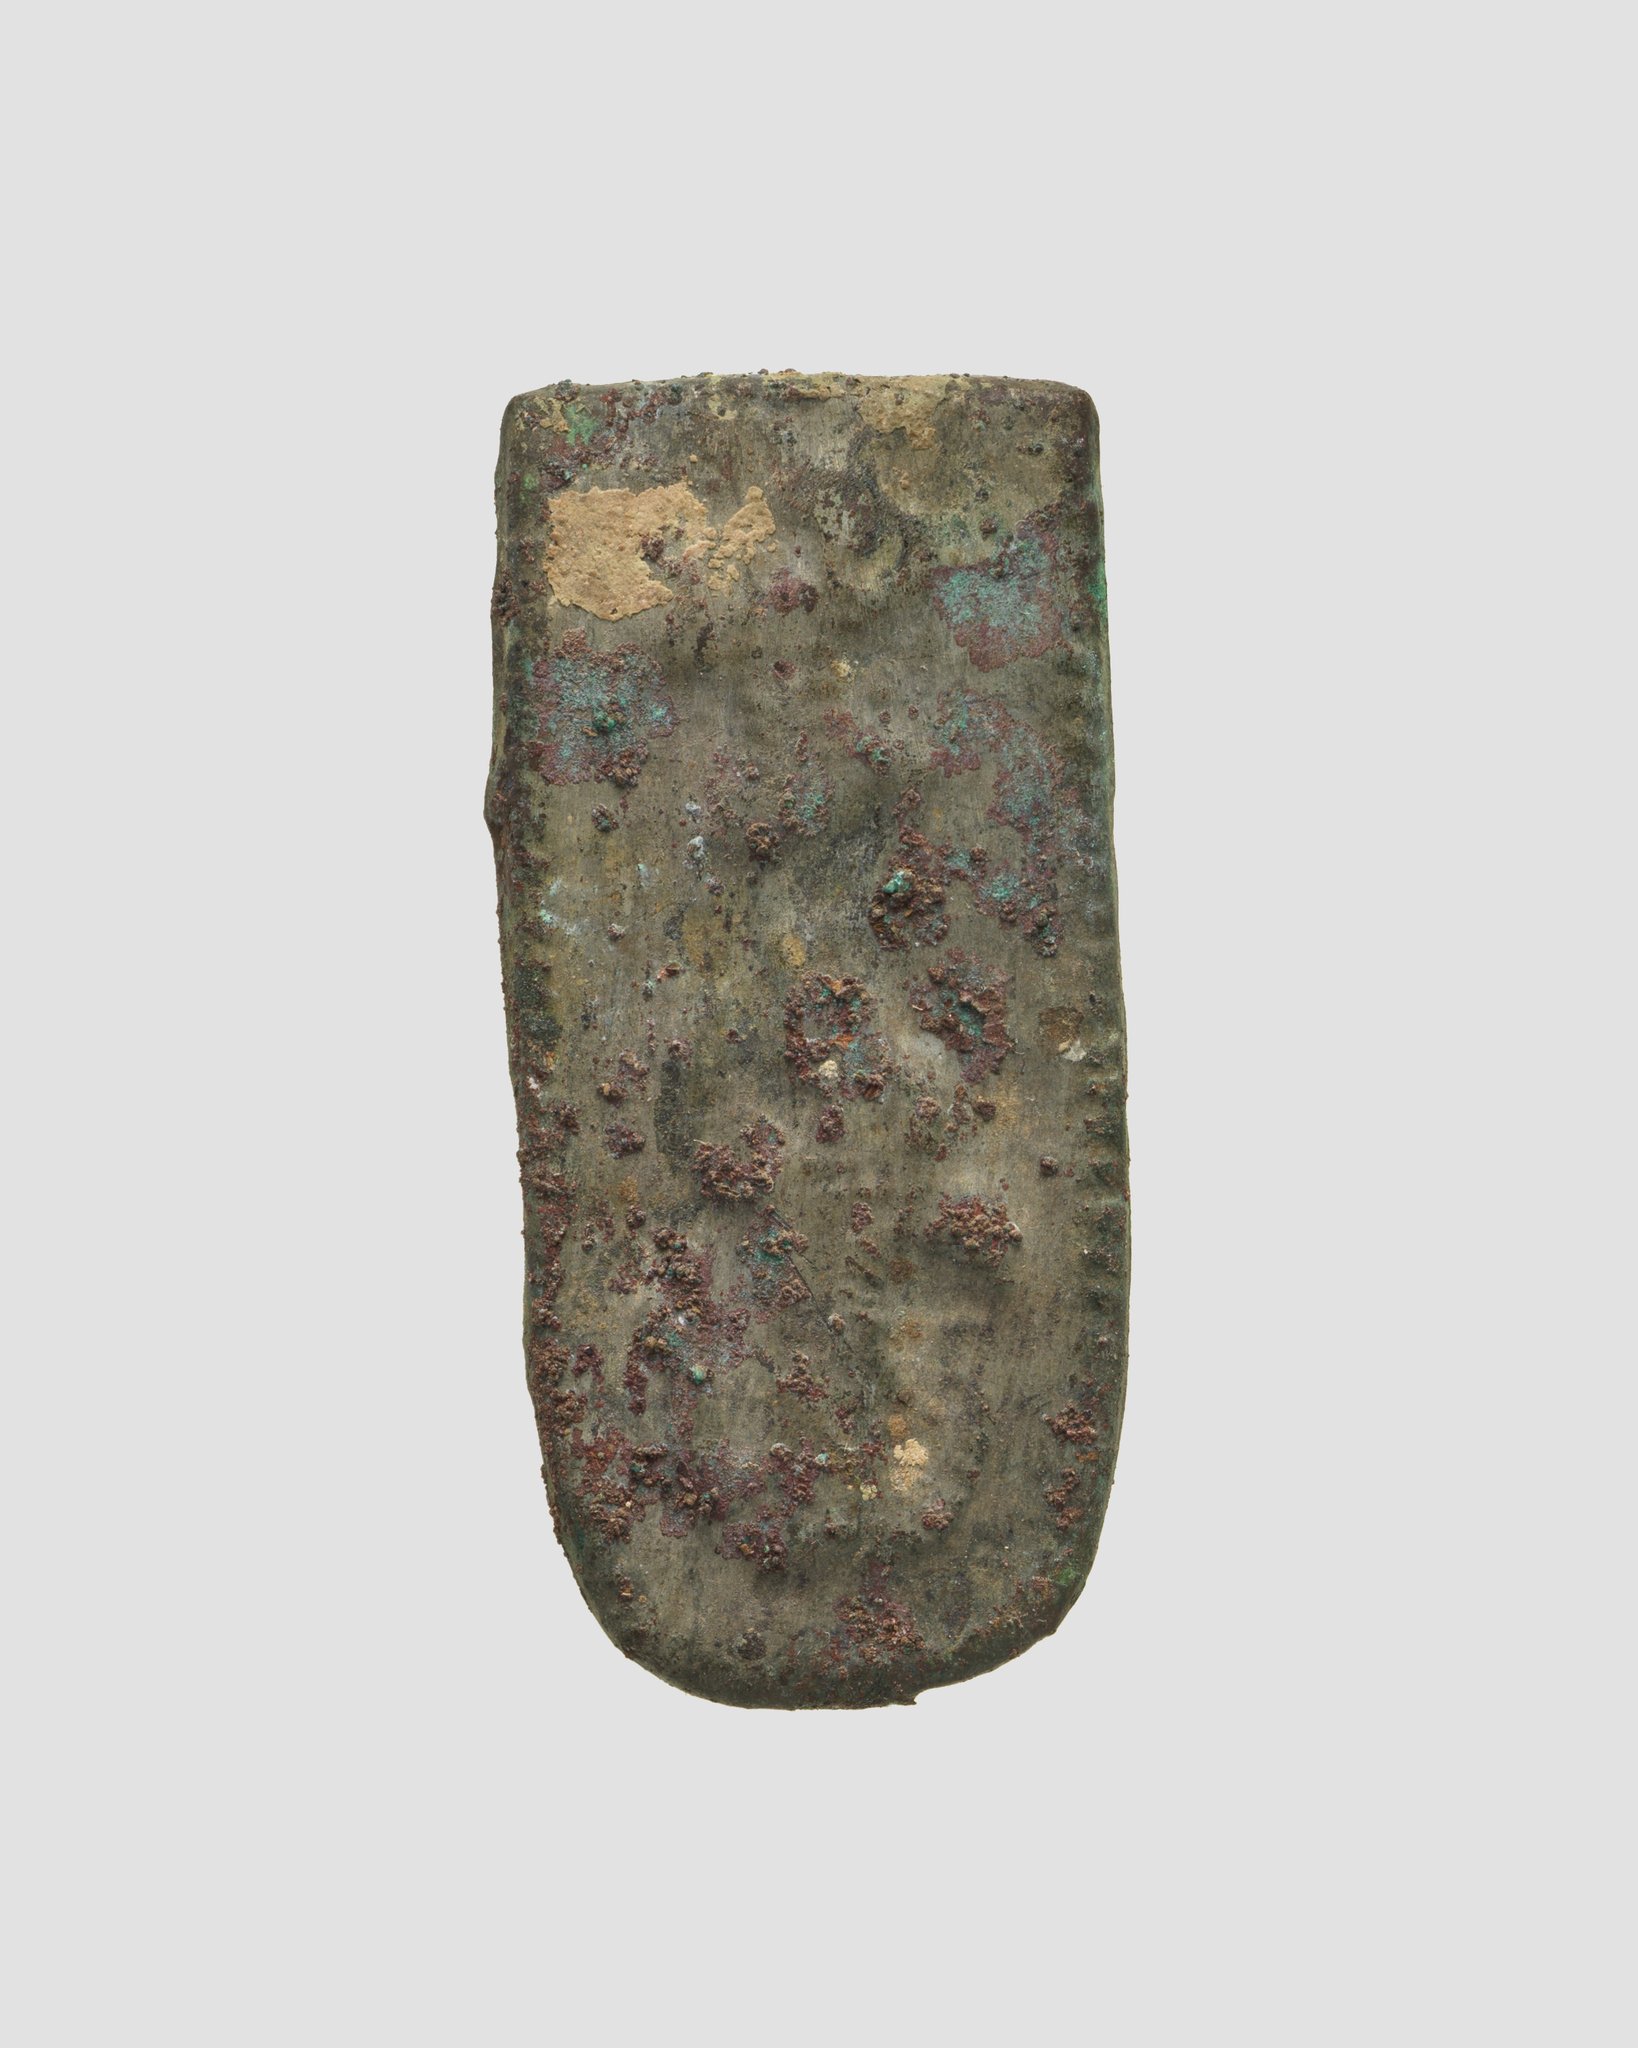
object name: belt tip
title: Bronze belt end tip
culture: alanic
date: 601-900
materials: metal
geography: caucasus